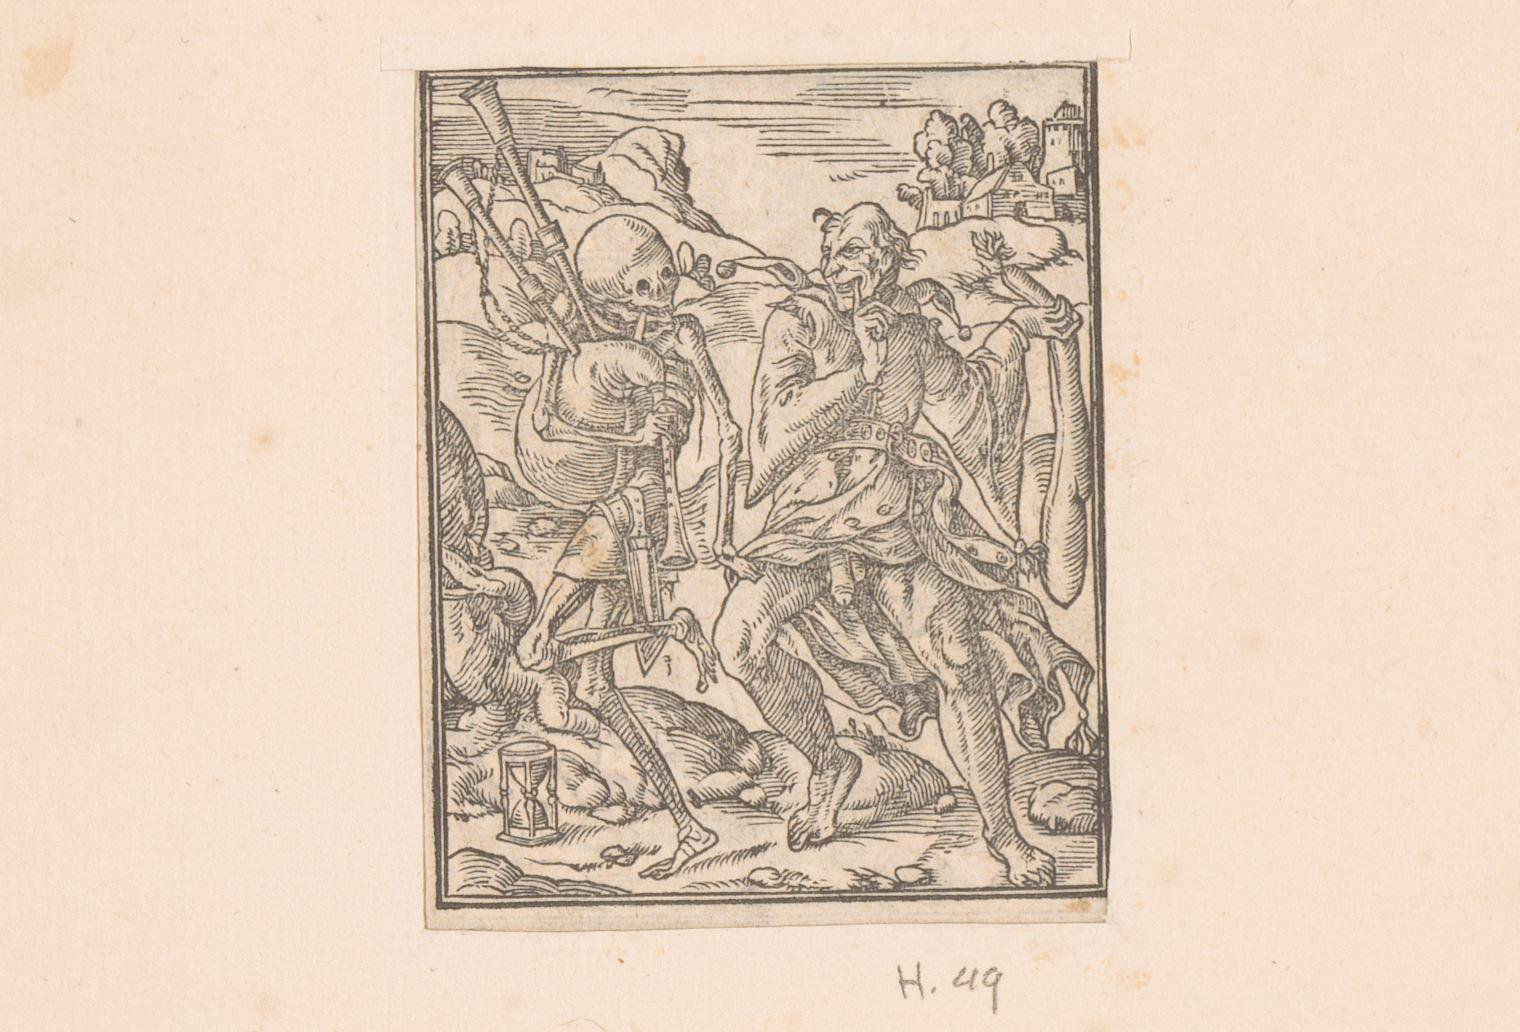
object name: book illustration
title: Kopieën naar Holbeins Dodendans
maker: Anonymous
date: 1547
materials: paper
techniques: woodcut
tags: dance of death; death together with one or more human beings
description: Kopie van een prent van Hans Holbein de jongere uit 1538, voor het eerst gepubliceerd in: Imagines mortis (...). Lyon: Johannes Frellon, 1547.